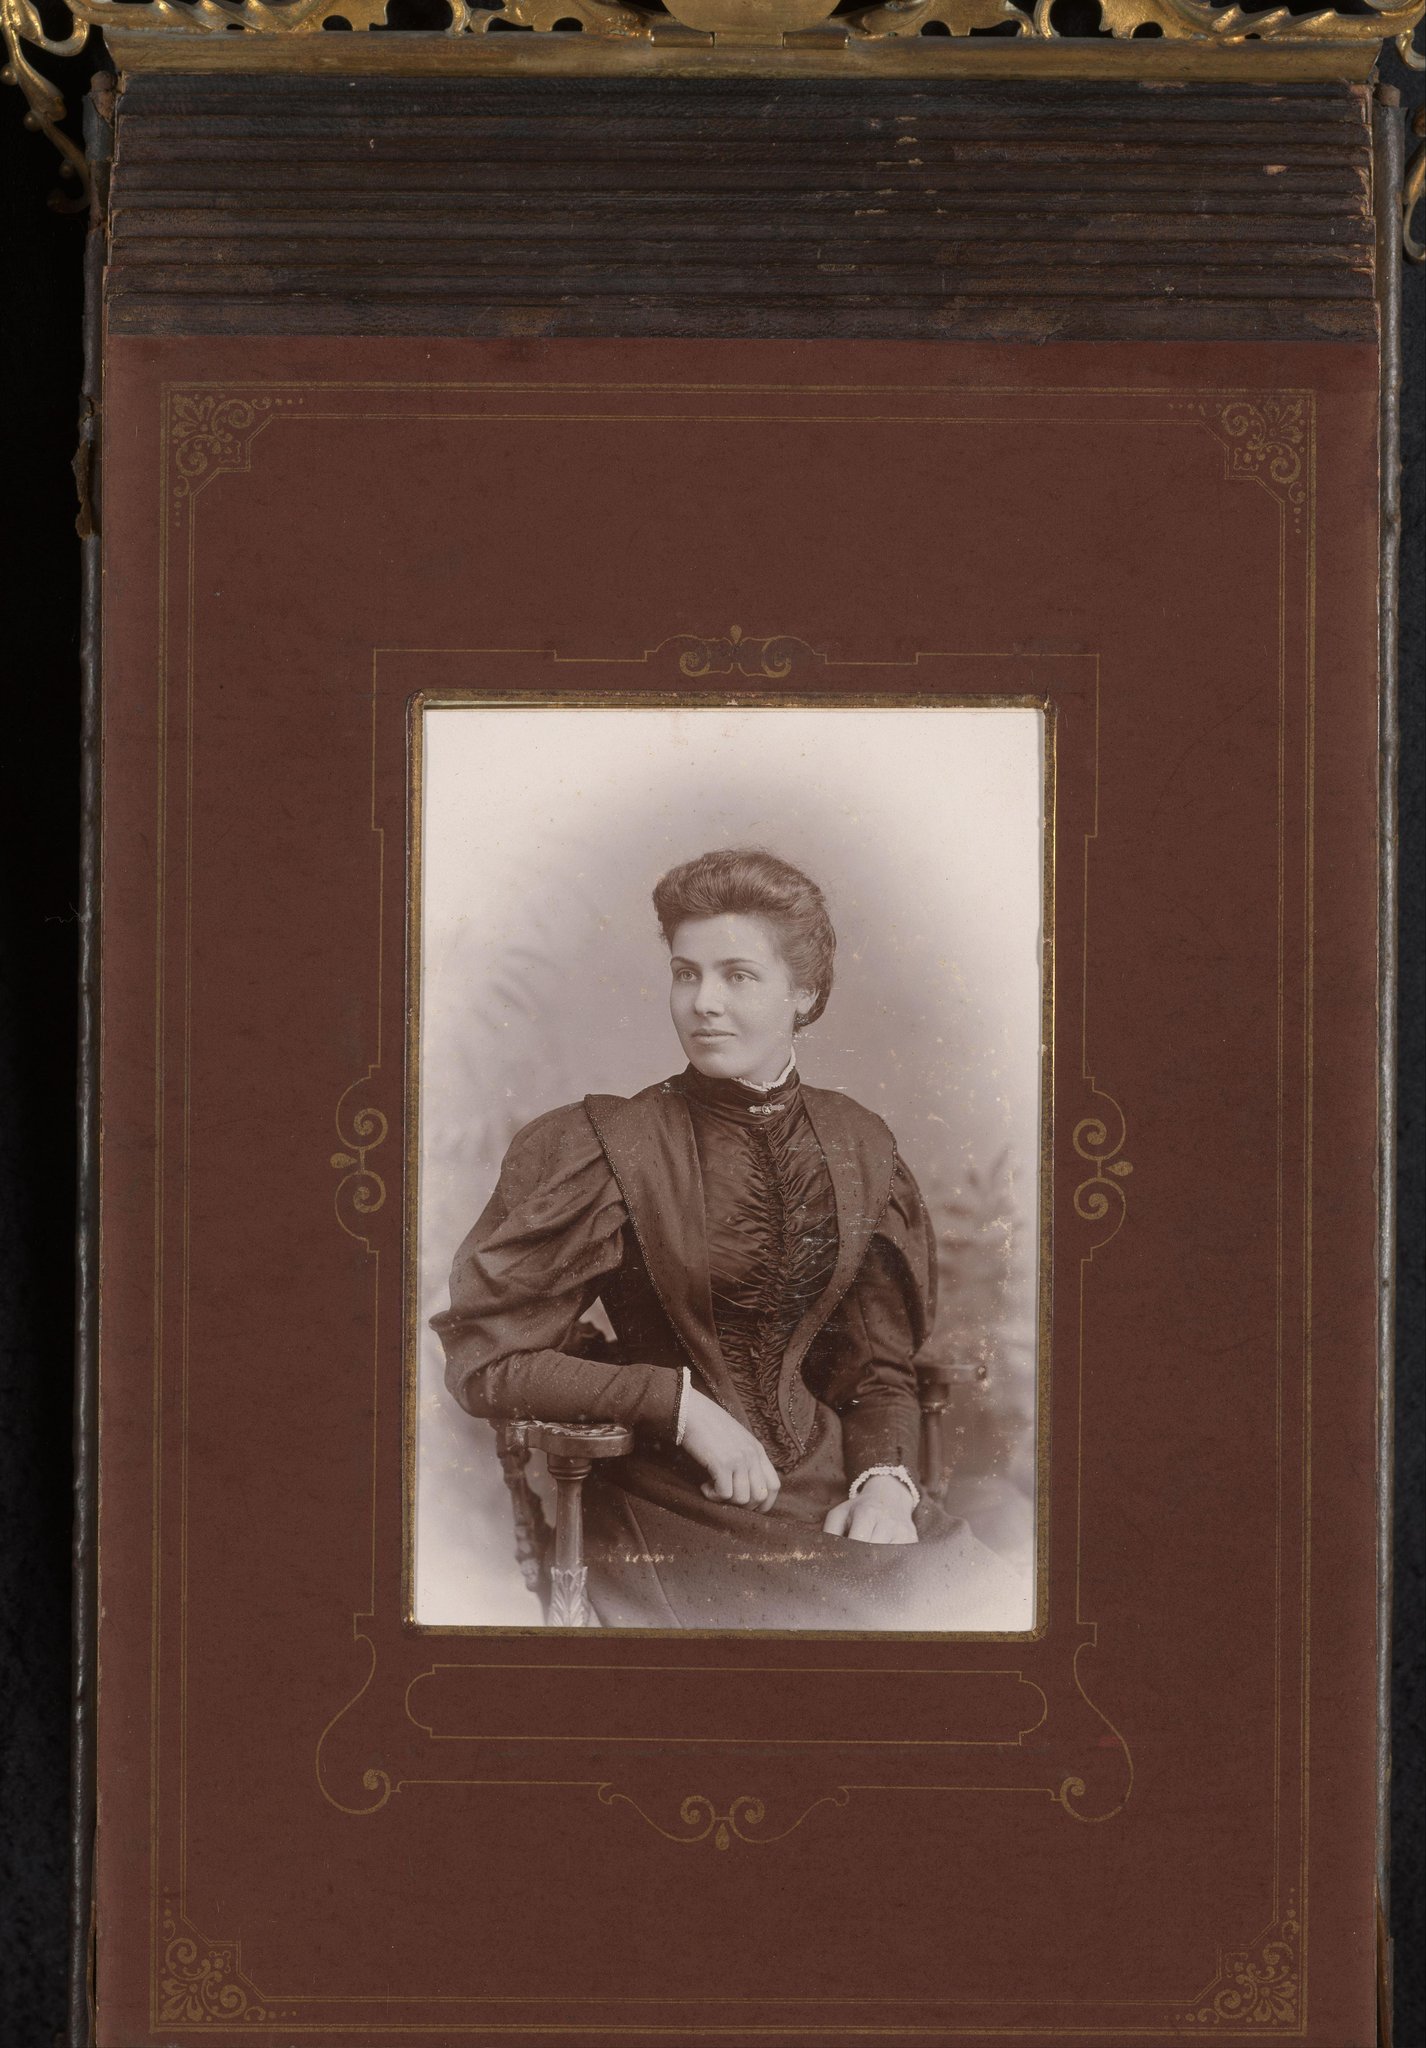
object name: cabinet photograph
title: Portret van een zittende vrouw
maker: Anonymous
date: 1880-1920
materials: cardboard, photographic support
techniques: collodion silver print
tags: sitting figure - aa - female human figure, historical persons - bb - woman